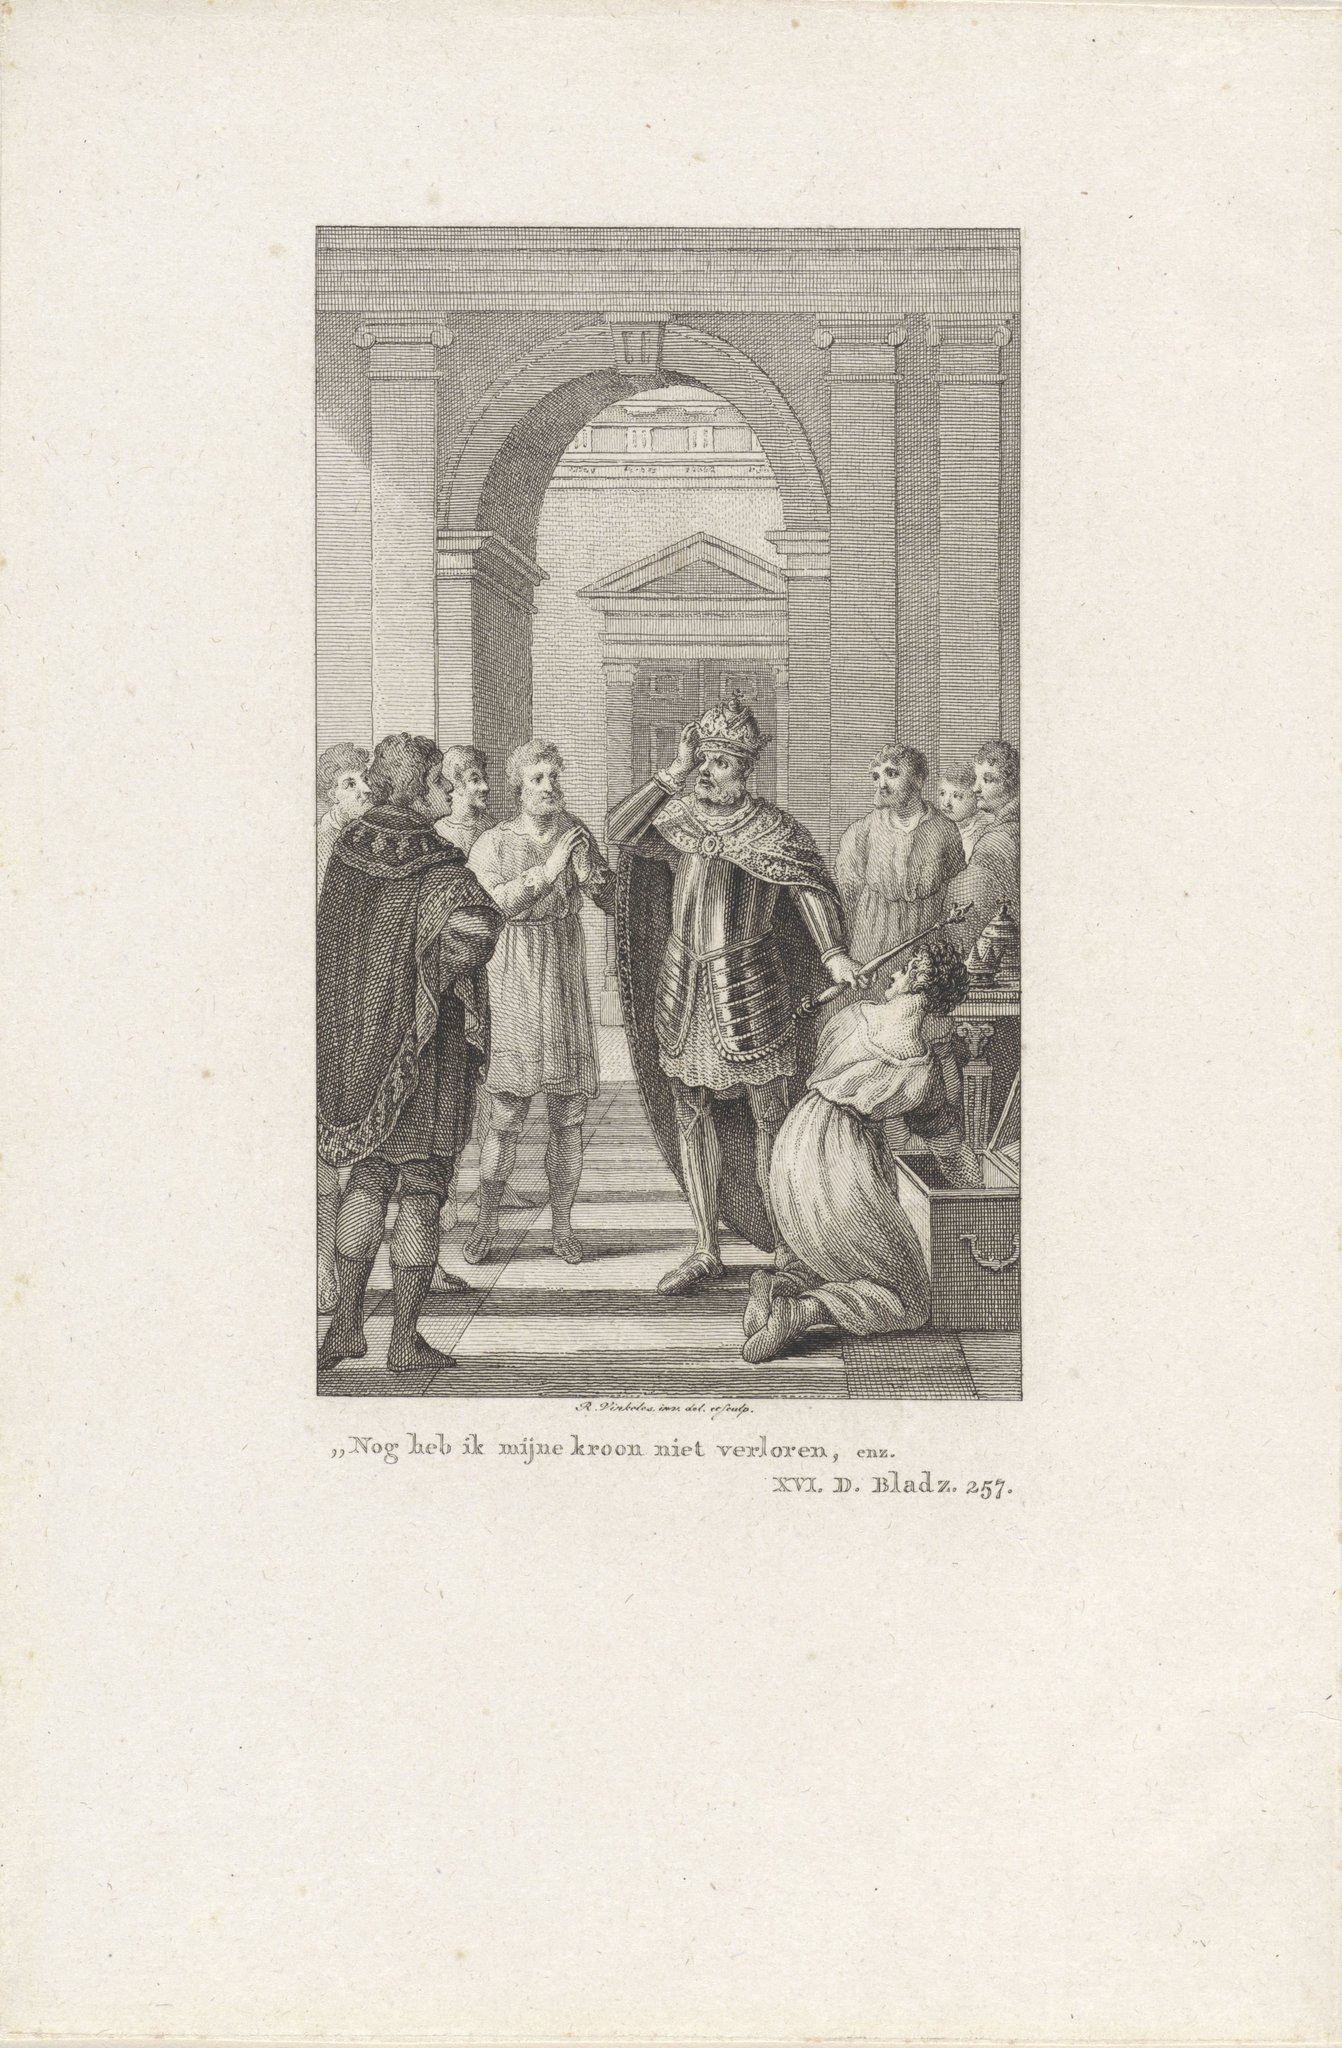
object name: book illustration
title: Keizer Frederik II grijpt naar zijn kroon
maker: reinier vinkeles (i)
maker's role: draughtsman, print maker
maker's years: 1741-1816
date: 1808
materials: paper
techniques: engraving, etching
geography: amsterdam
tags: crown (symbol of sovereignty)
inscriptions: collector's mark: Lugt 2228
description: Deze prent is ook gebruikt als illustratie in: Hamelsveld, Ysbrand van. Algemeene kerkelijke geschiedenis, der Christenen, deel 16. Haarlem: François Bohn, 1808, p. 257.